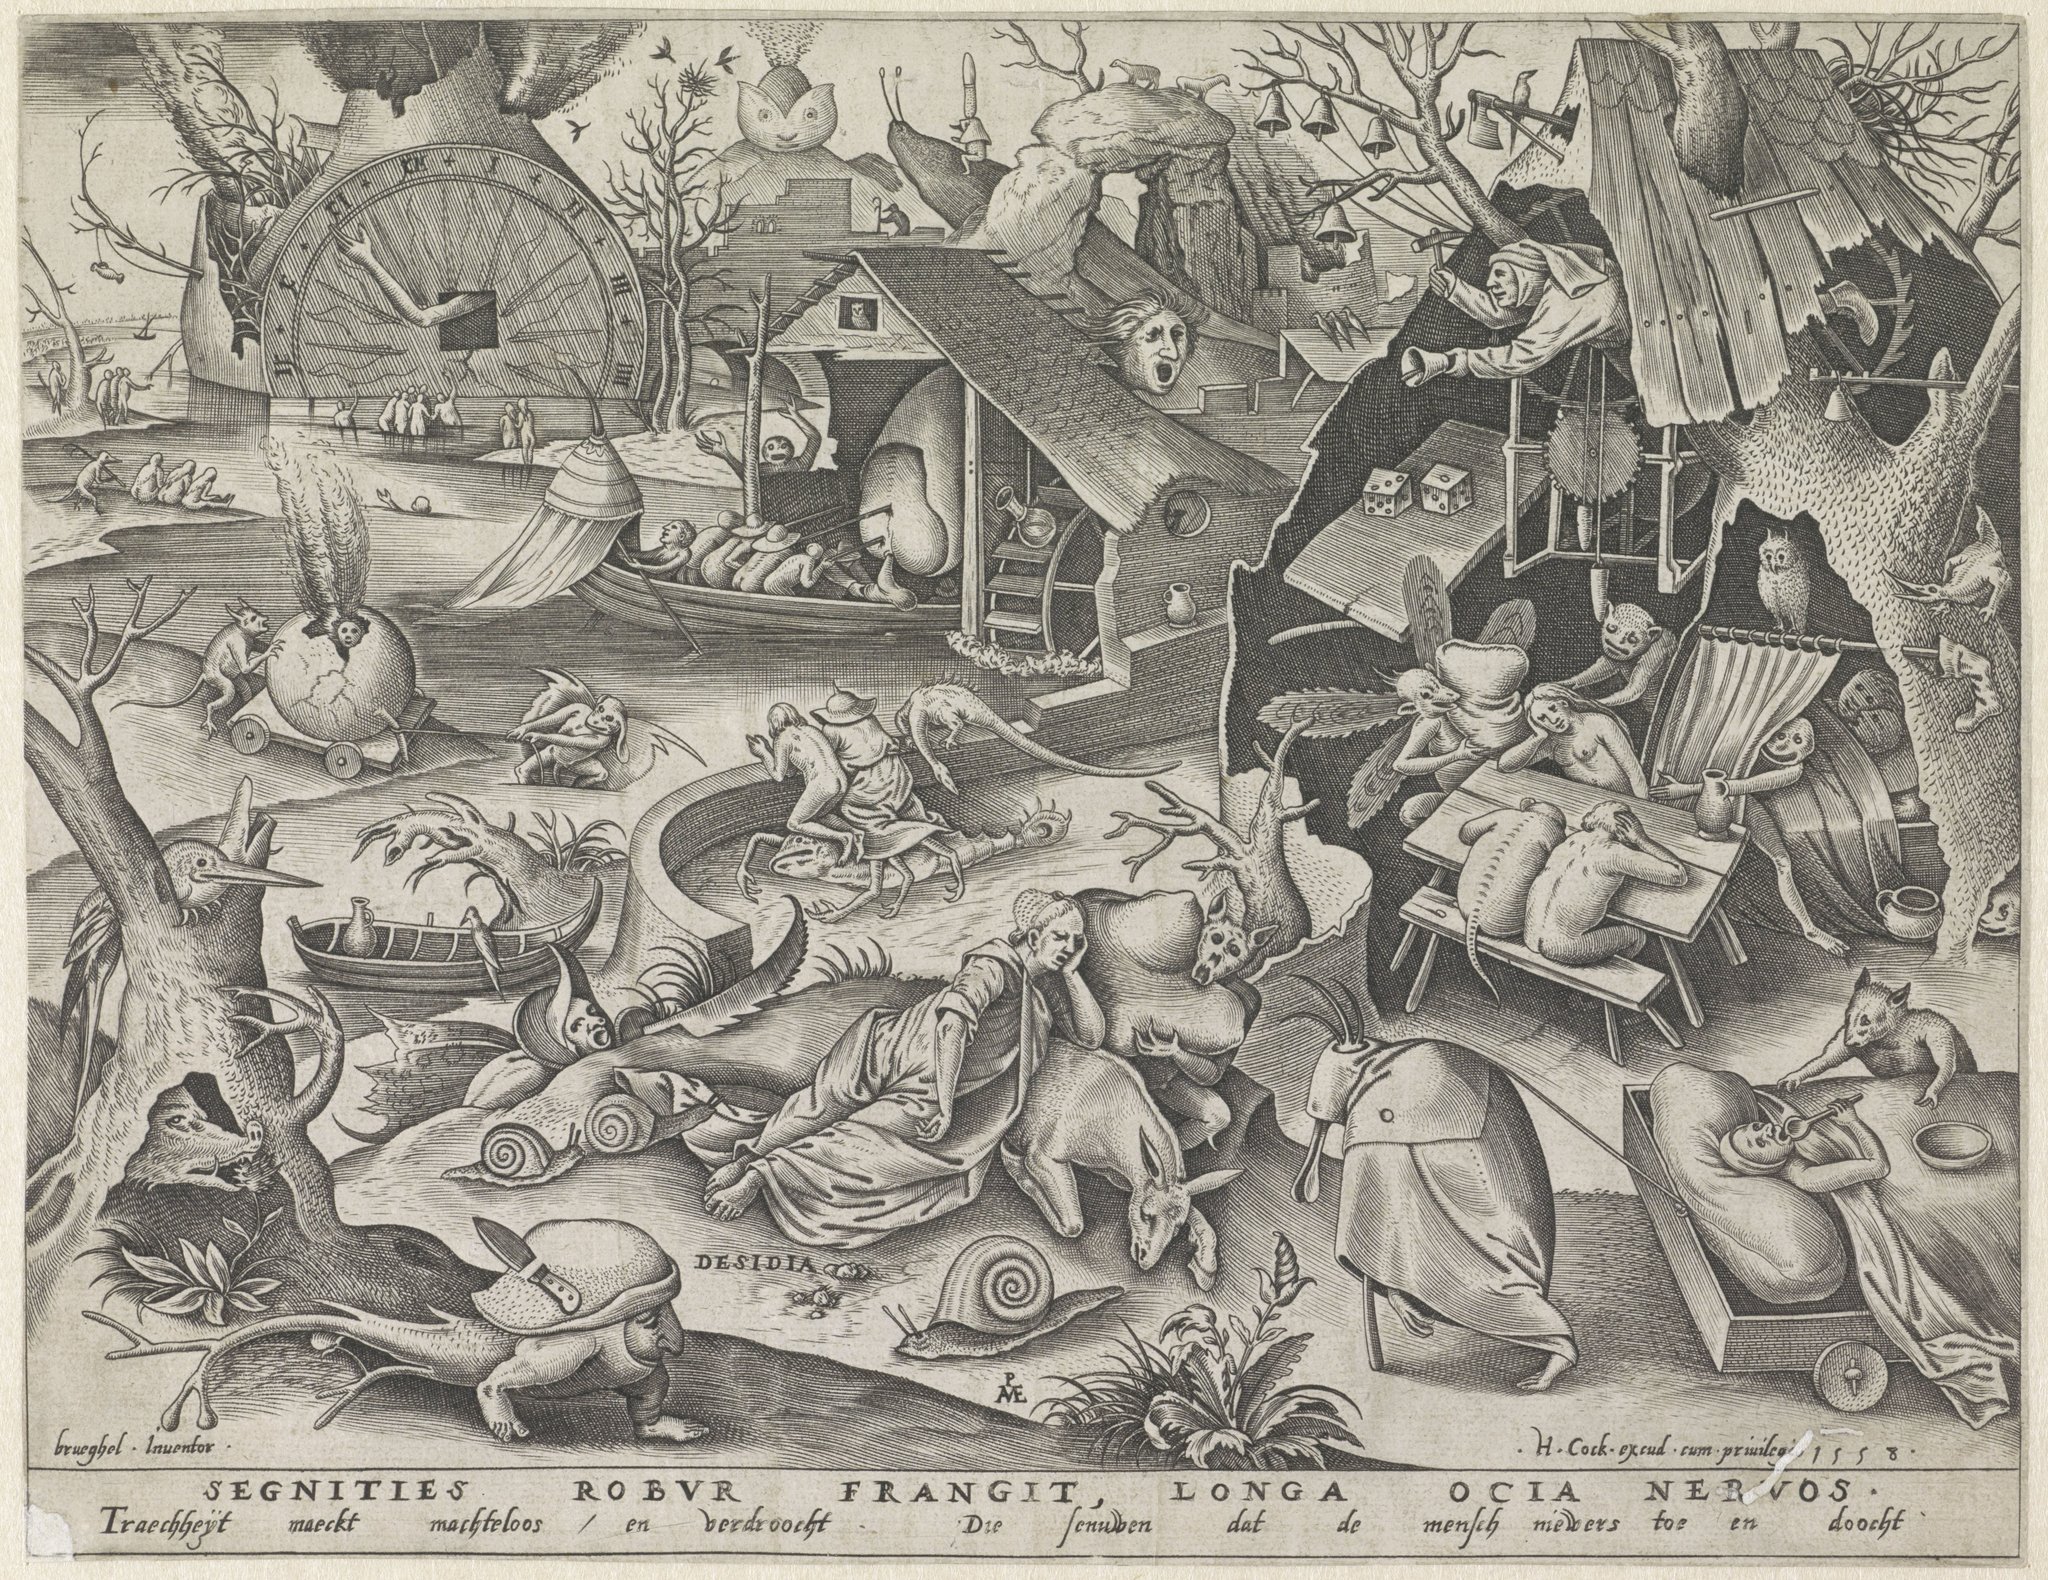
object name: print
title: De zeven hoofdzonden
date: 1558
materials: paper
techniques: engraving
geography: antwerp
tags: sloth, indolence, 'acedia', 'desidia'; 'accidia' (ripa) ~ personification of one of the seven deadly sins, devils in the form of (fabulous) animals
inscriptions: collector's mark: Lugt 2228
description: Vrouwelijke personificatie van de Luiheid (Desidia) slapend geleund tegen een ezel en vergezeld door slakken. Hieromheen allerlei fantastische scènes en gedrochten waarmee deze hoofdzonde wordt uitgebeeld. Met onderschrift van een regel in het Latijn en een regel in het Nederlands.